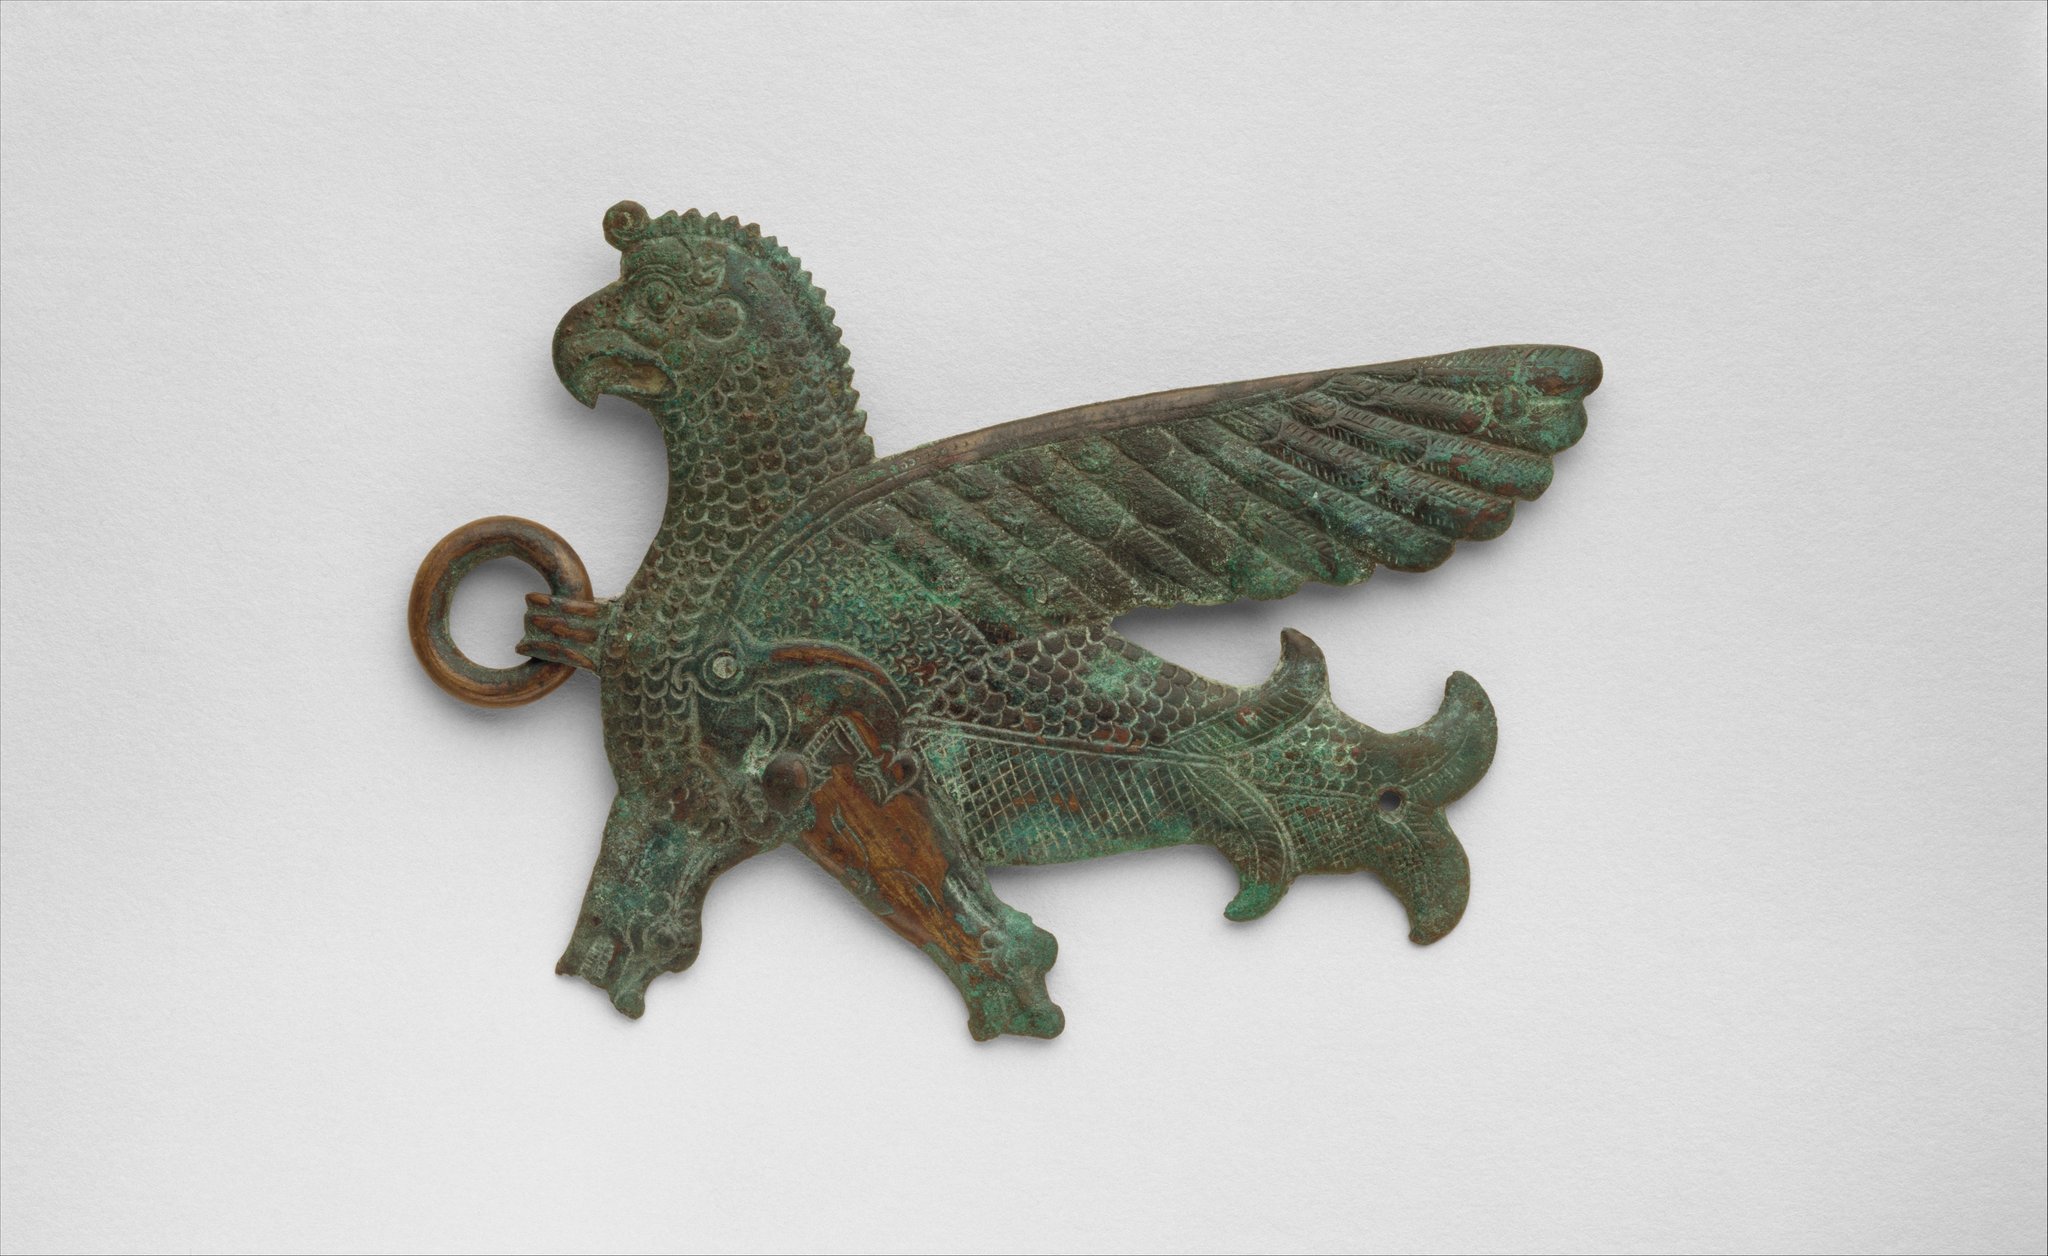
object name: belt ornament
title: Belt ornament in the form of a bird demon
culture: urartian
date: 734-601 BCE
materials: bronze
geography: urartu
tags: birds,demons